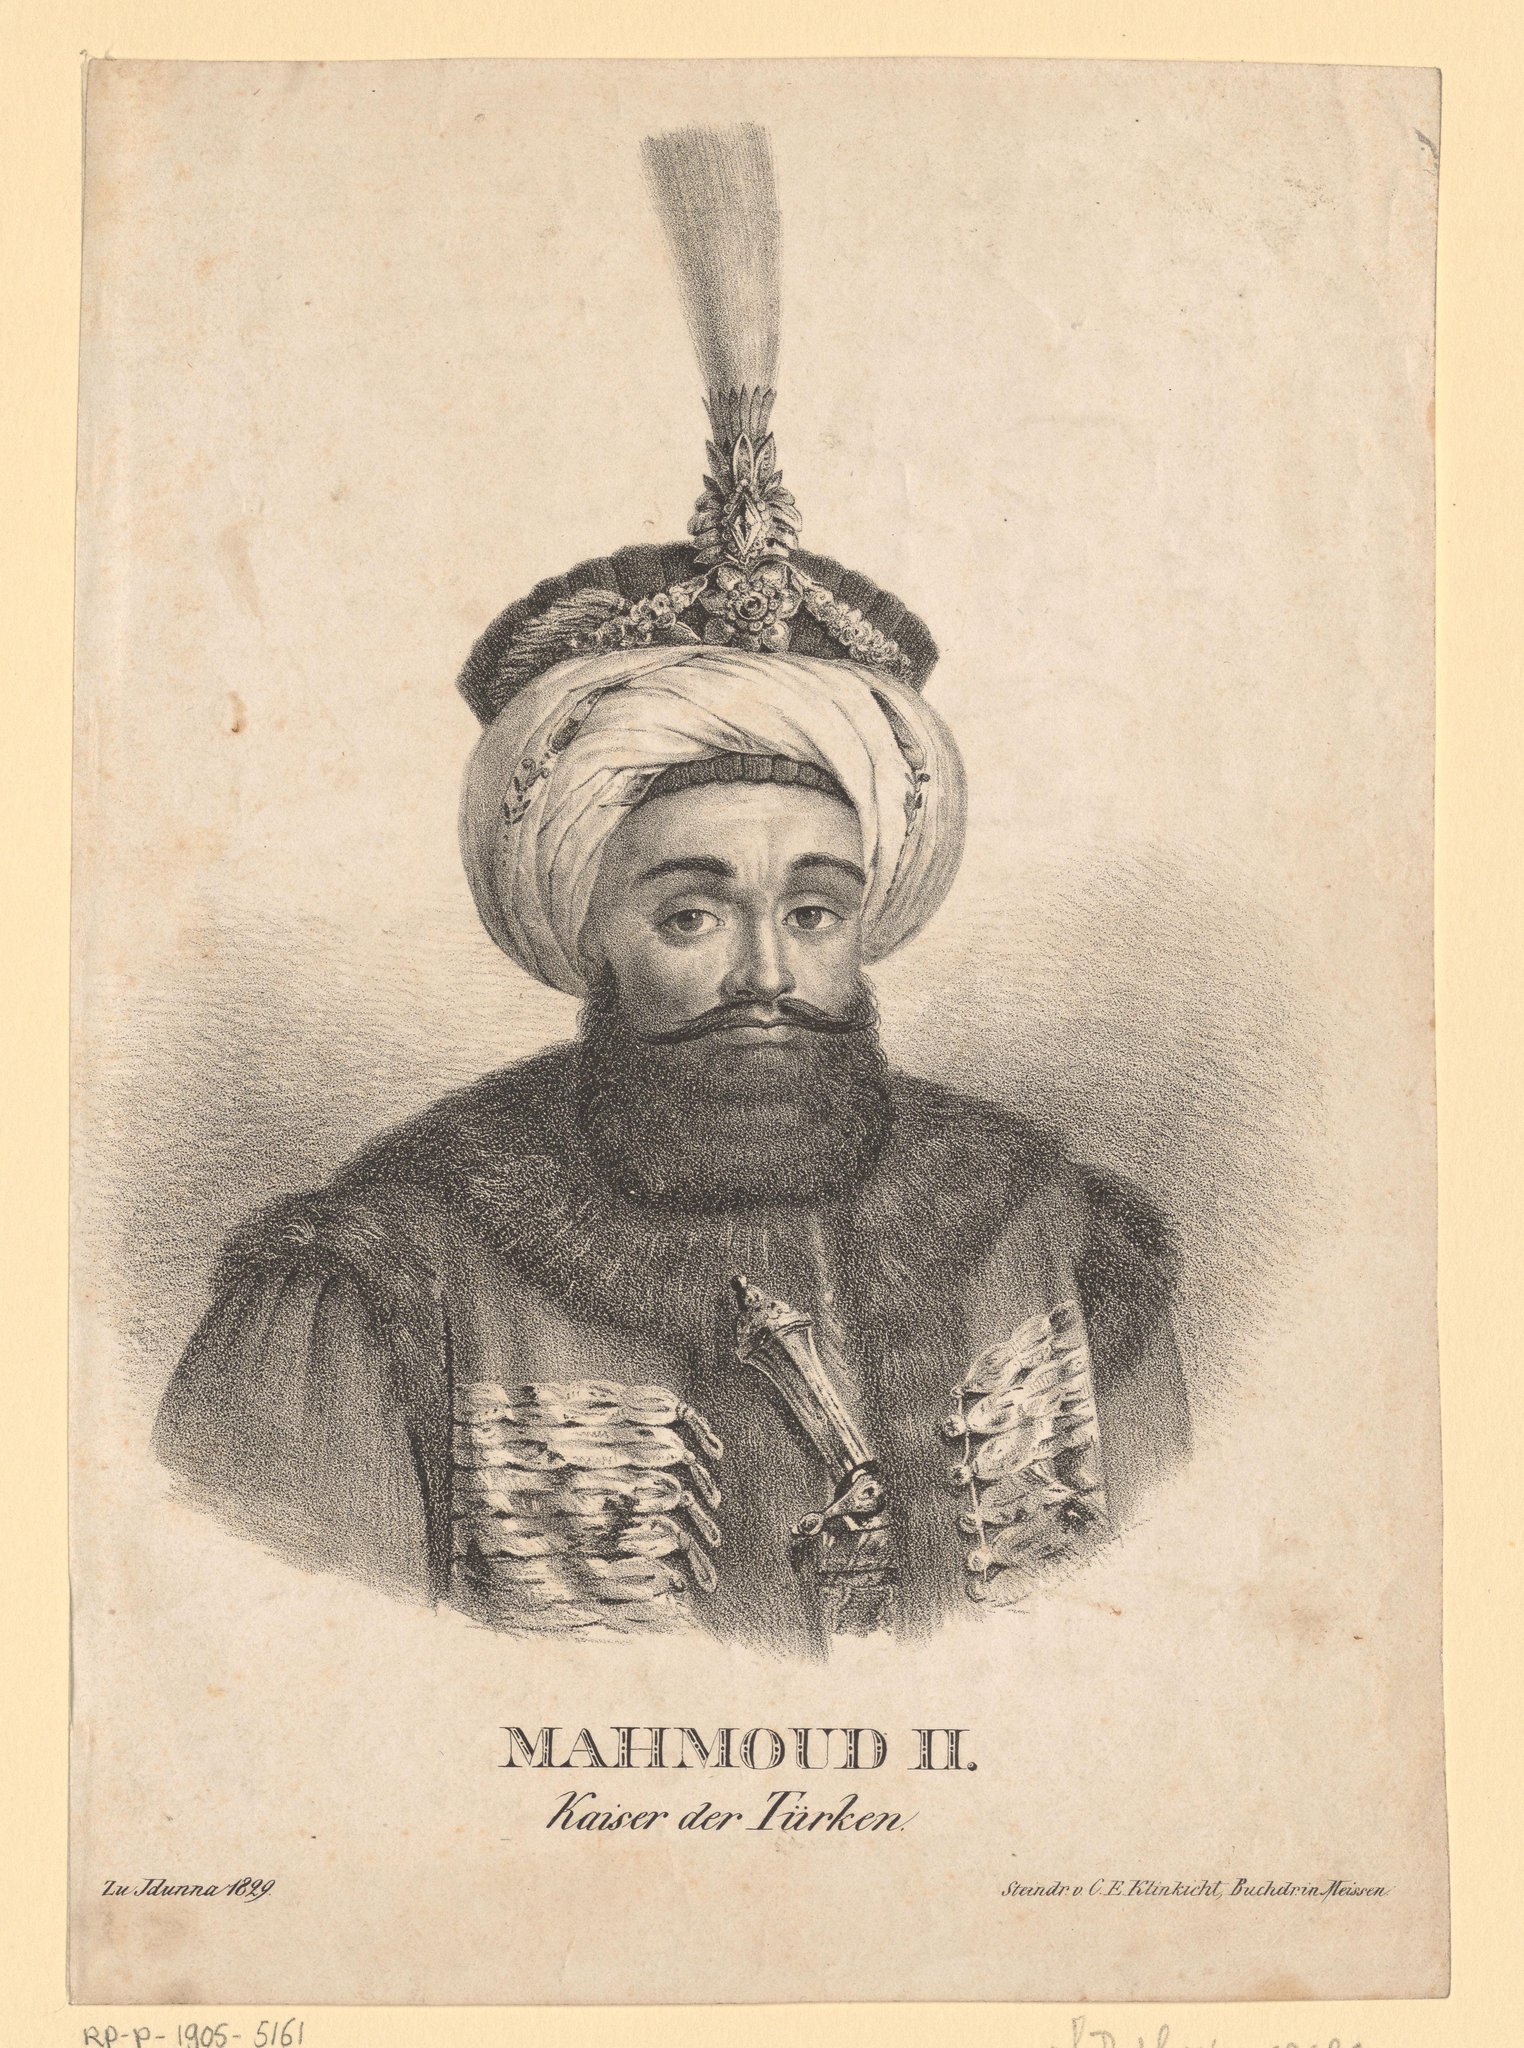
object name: print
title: Portret van Mahmut II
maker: Anonymous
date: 1829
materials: paper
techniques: lithograph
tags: historical persons, head-gear: turban, ruler, sovereign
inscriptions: collector's mark: Lugt 2228